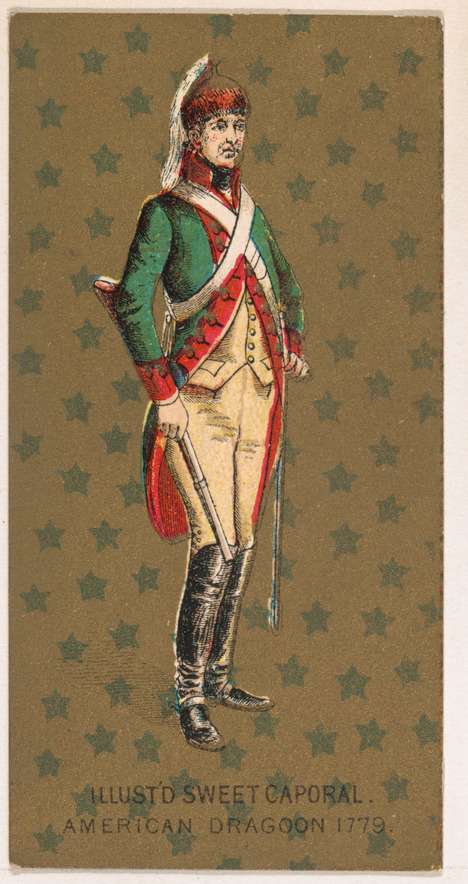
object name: print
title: American Dragoon, 1779, from the Military Series (N224) issued by Kinney Tobacco Company to promote Sweet Caporal Cigarettes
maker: kinney brothers tobacco company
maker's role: publisher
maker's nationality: american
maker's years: 1869-2011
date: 1888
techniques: color lithograph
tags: military,men